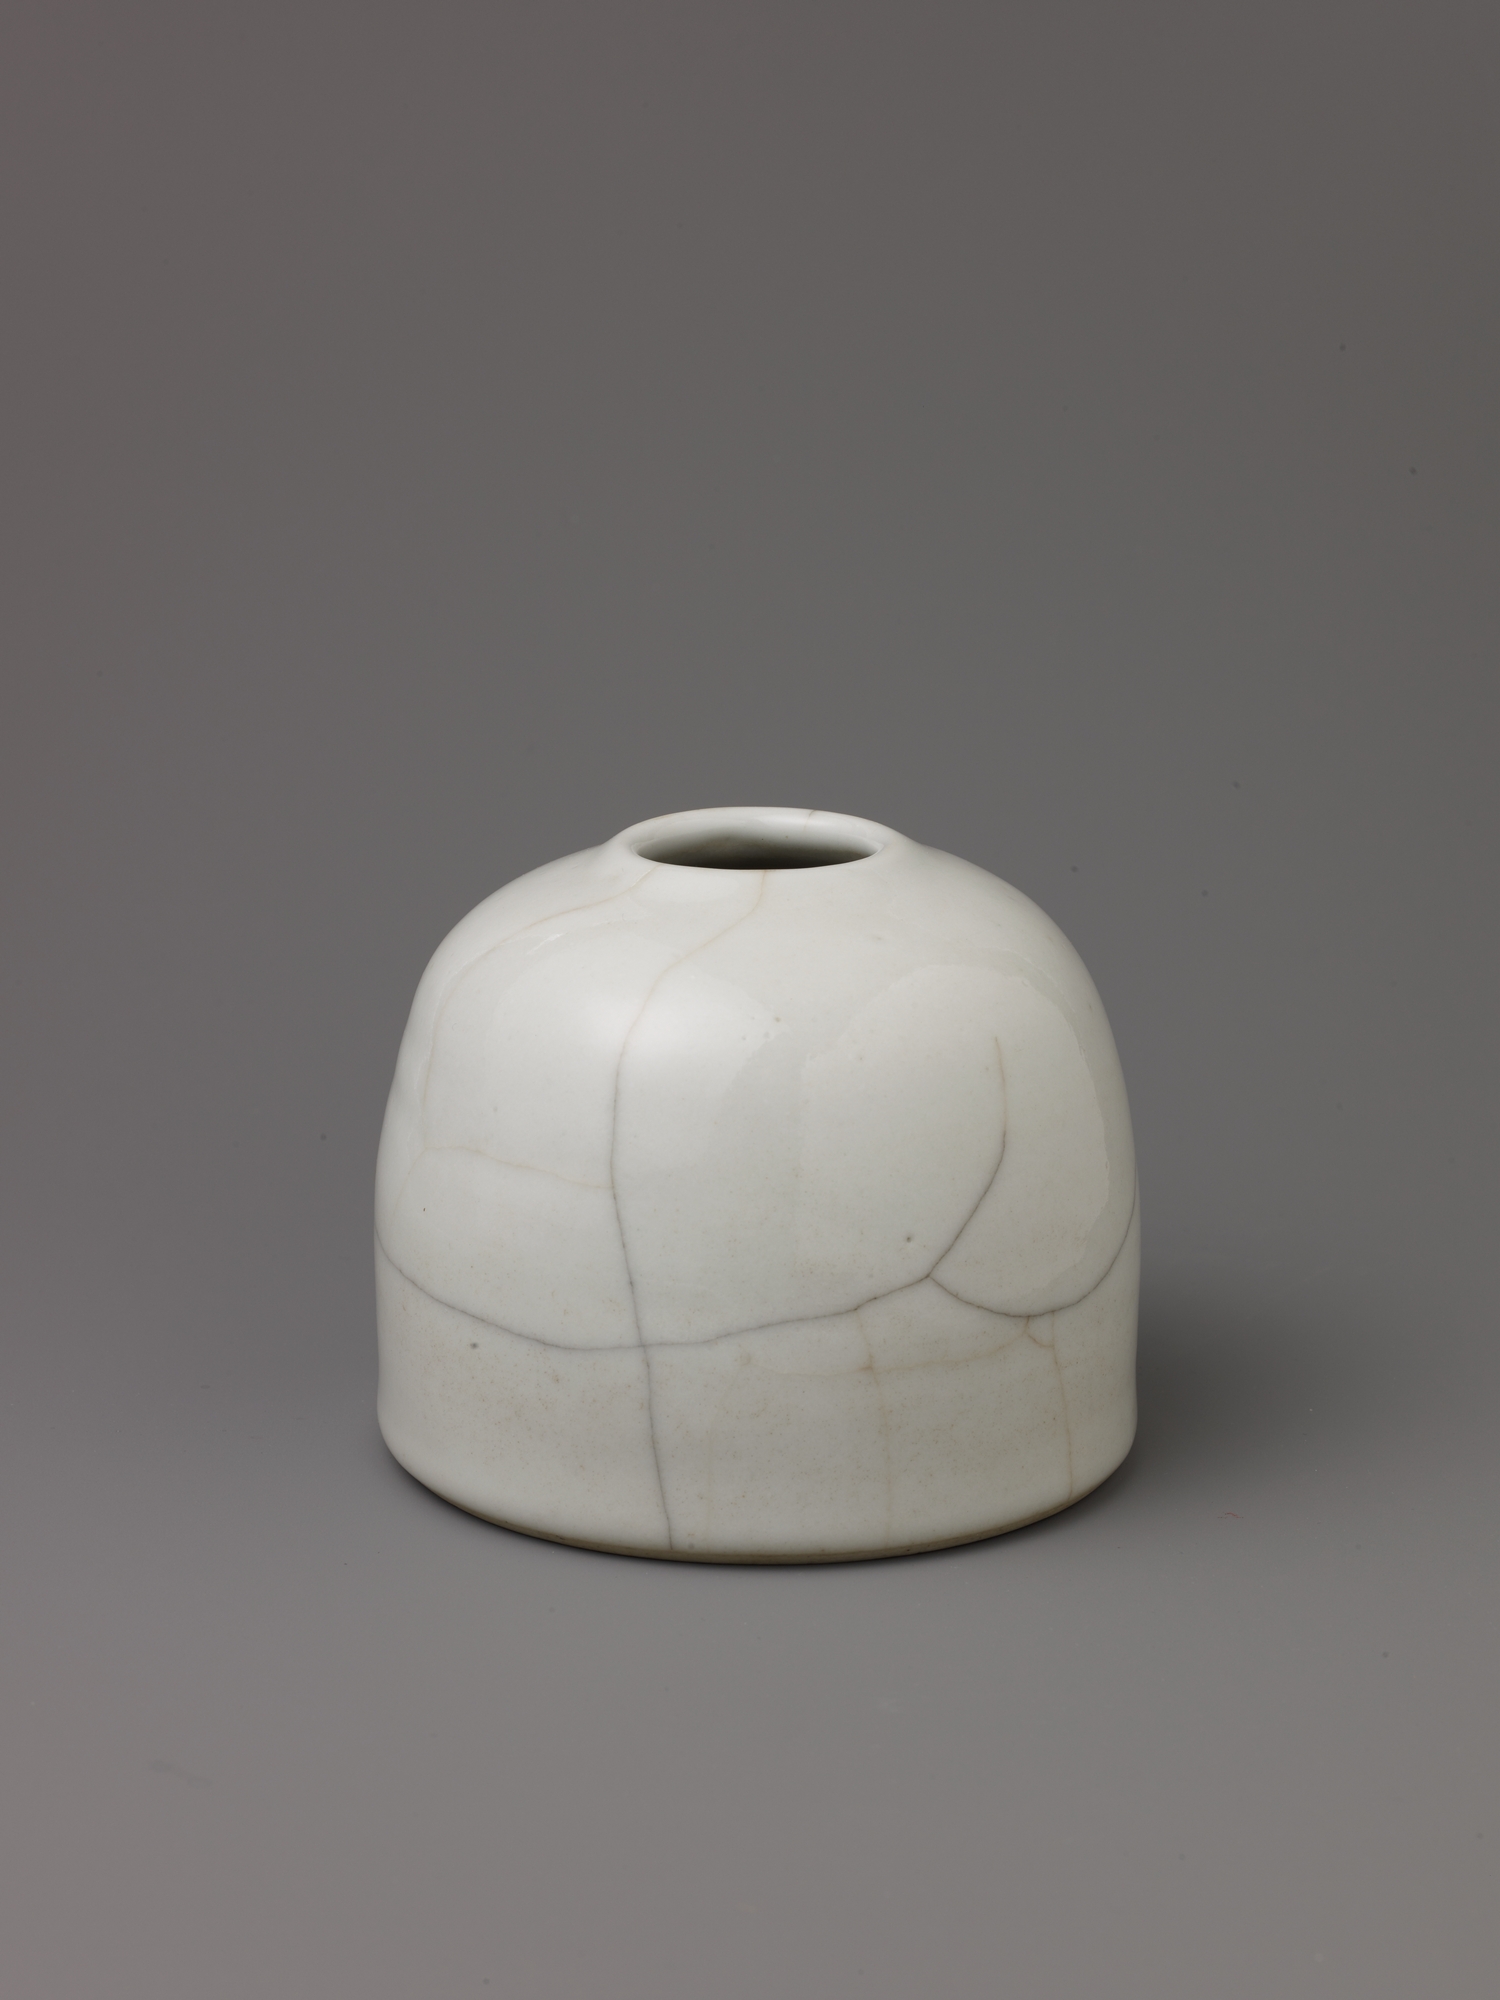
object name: pot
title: Water pot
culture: chinese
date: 1801-1900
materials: glaze, porcelain